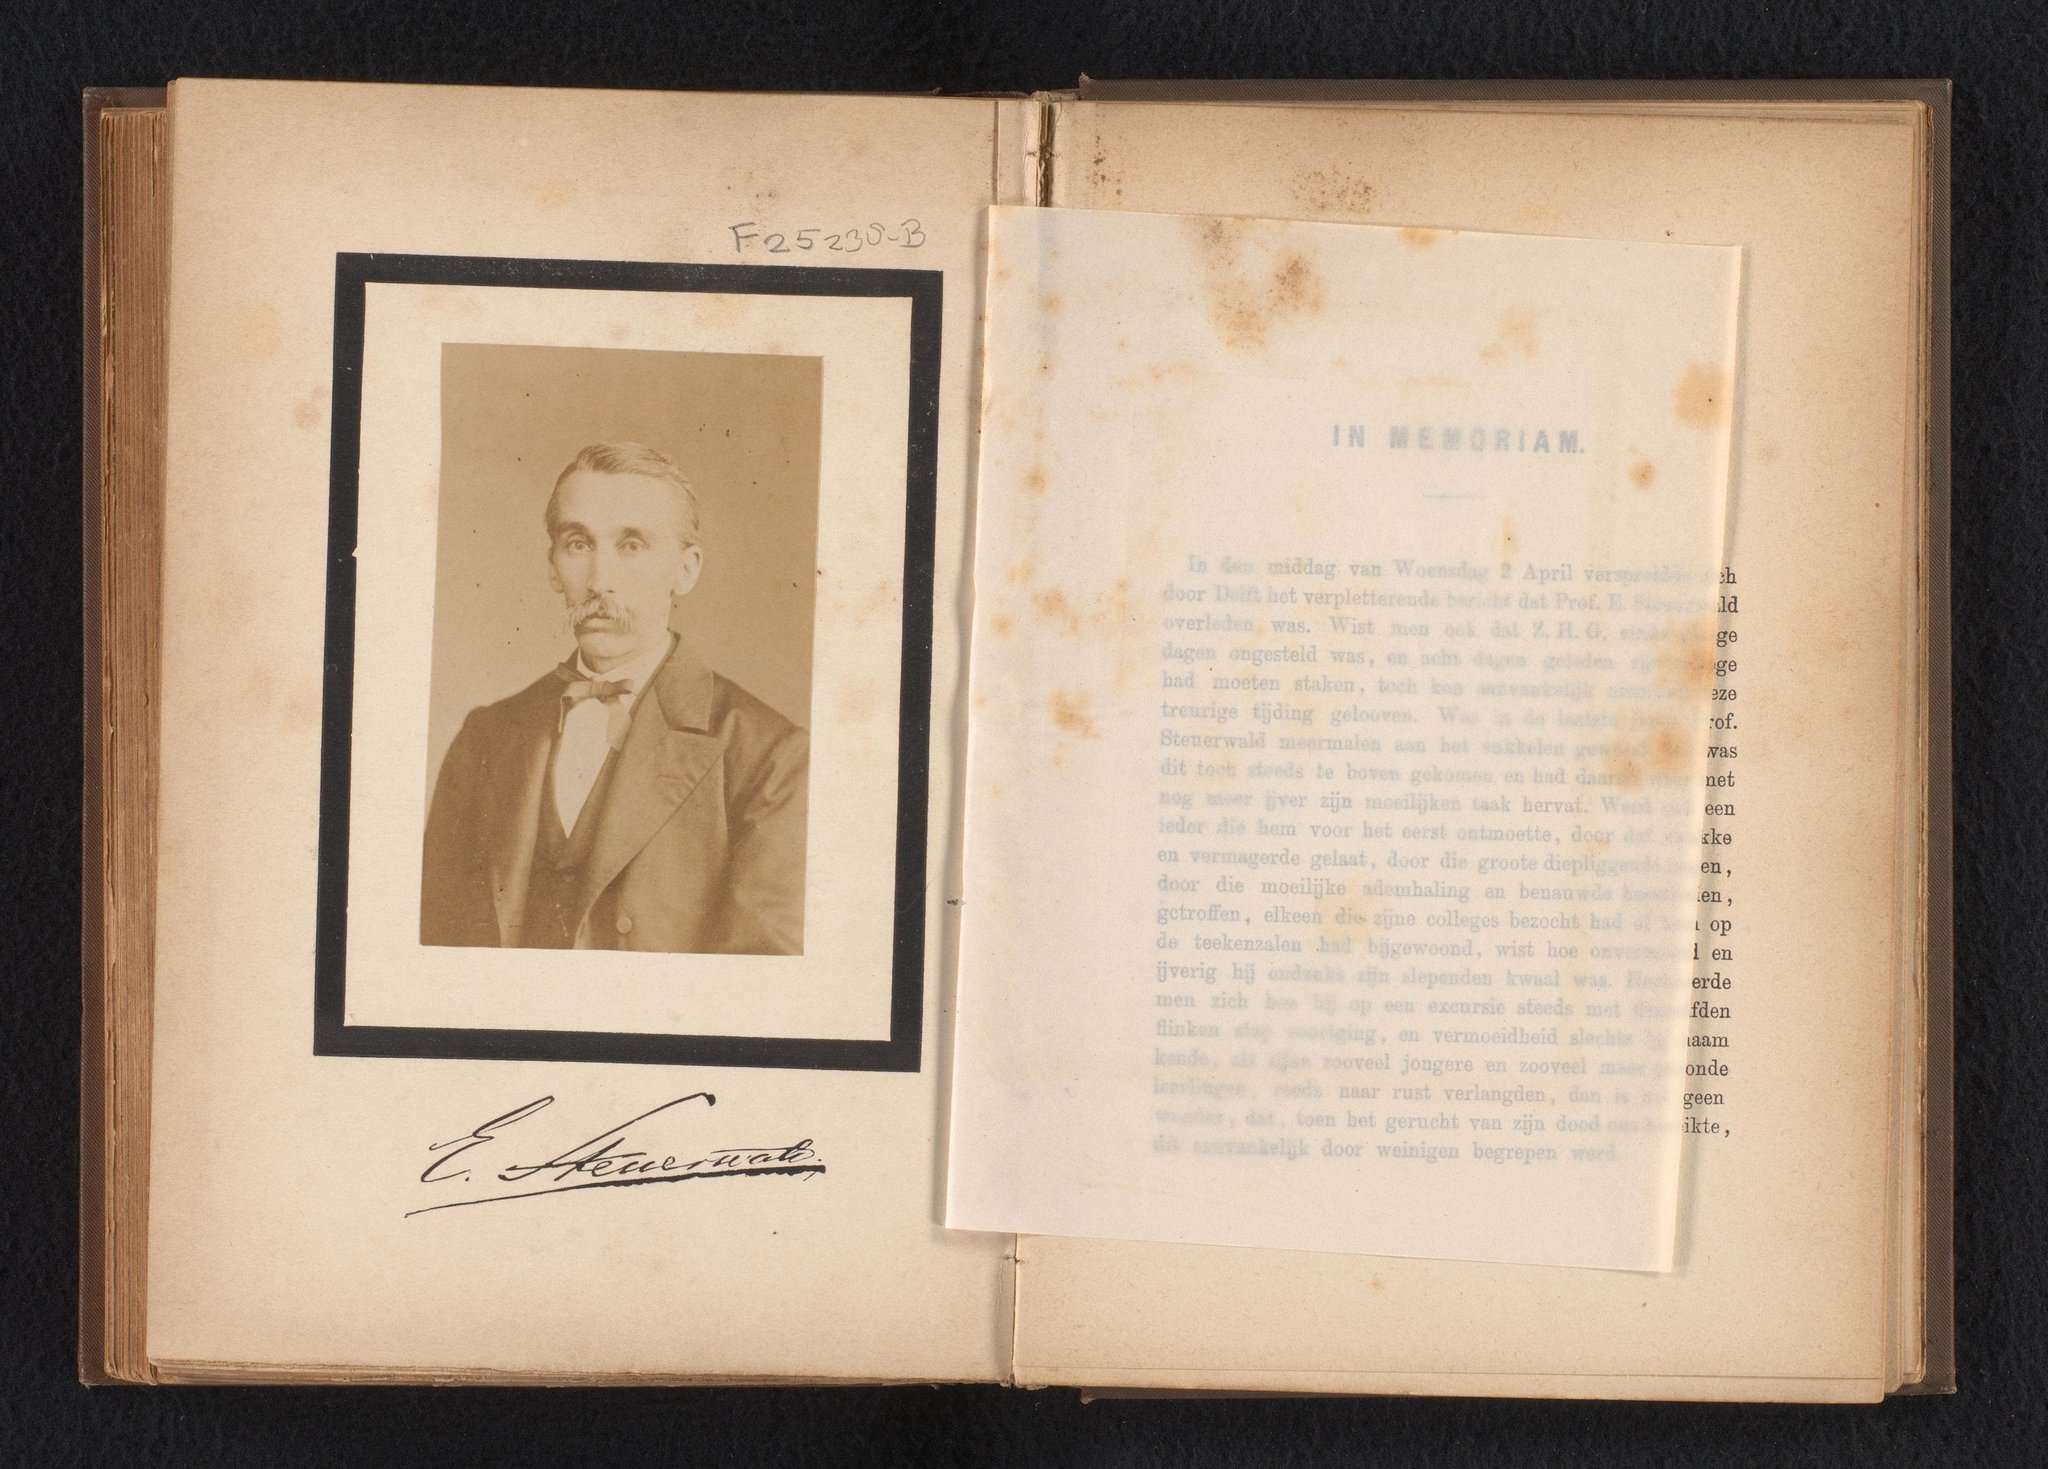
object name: page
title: Portret van Ernst Steuerwald, hoogleraar Waterbouwkunde aan de Polytechnische School Delft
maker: Anonymous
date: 1884-1885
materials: paper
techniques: albumen print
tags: delft, engineer, historical persons, professor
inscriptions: signature: ‘E. Steuerwald’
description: Foto op ongenummerde pagina tegenover pagina 403.